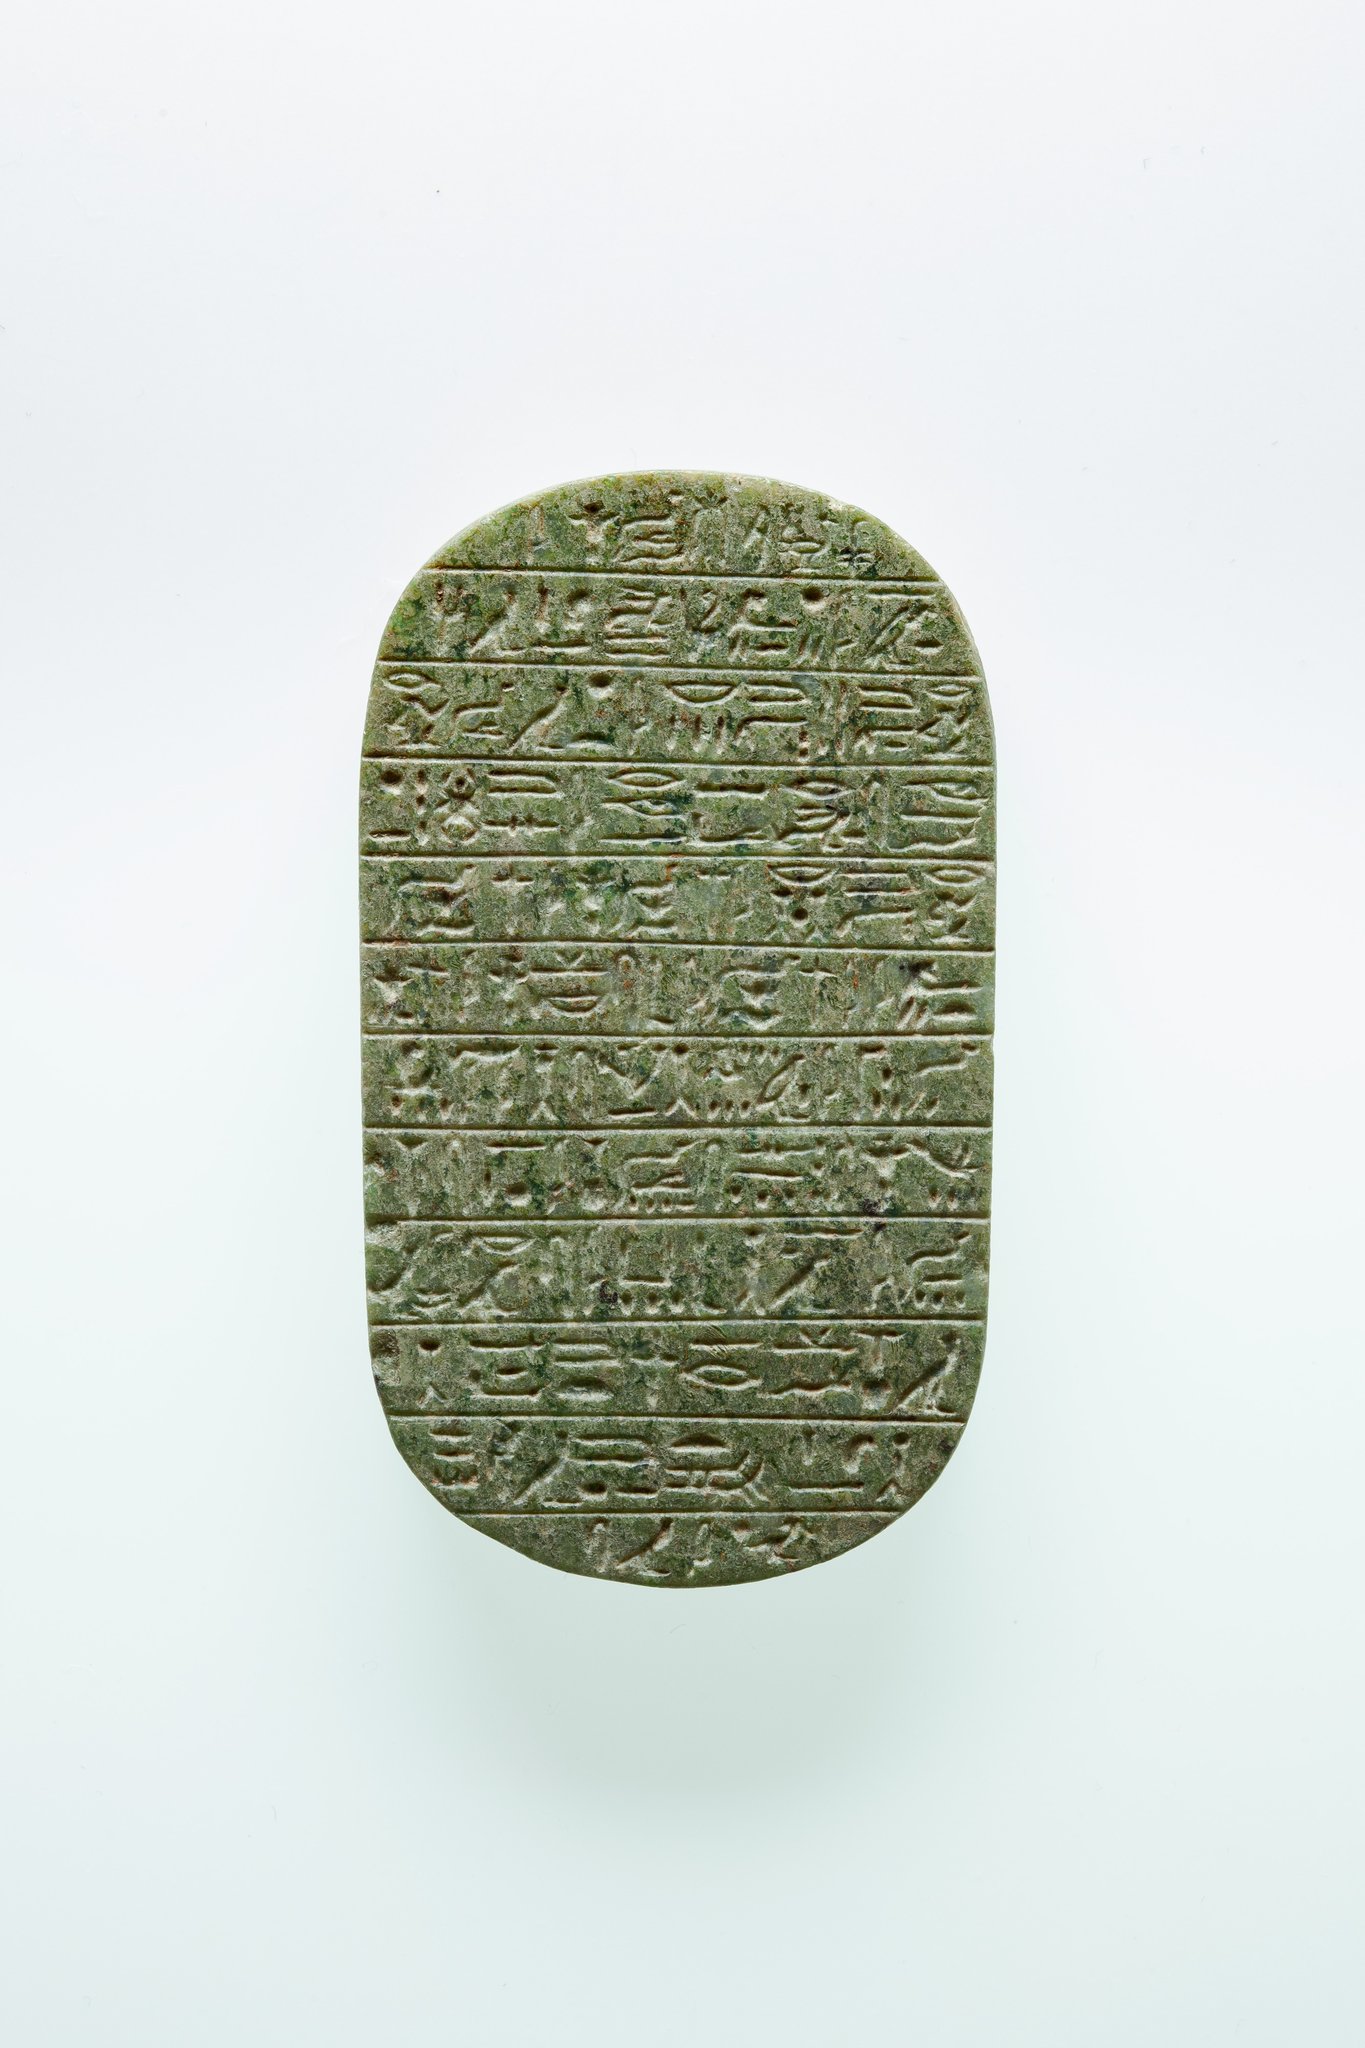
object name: plaque, heart scarab text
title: Plaque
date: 1550-1295 BCE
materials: stone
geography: egypt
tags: hieroglyphs,scarabs